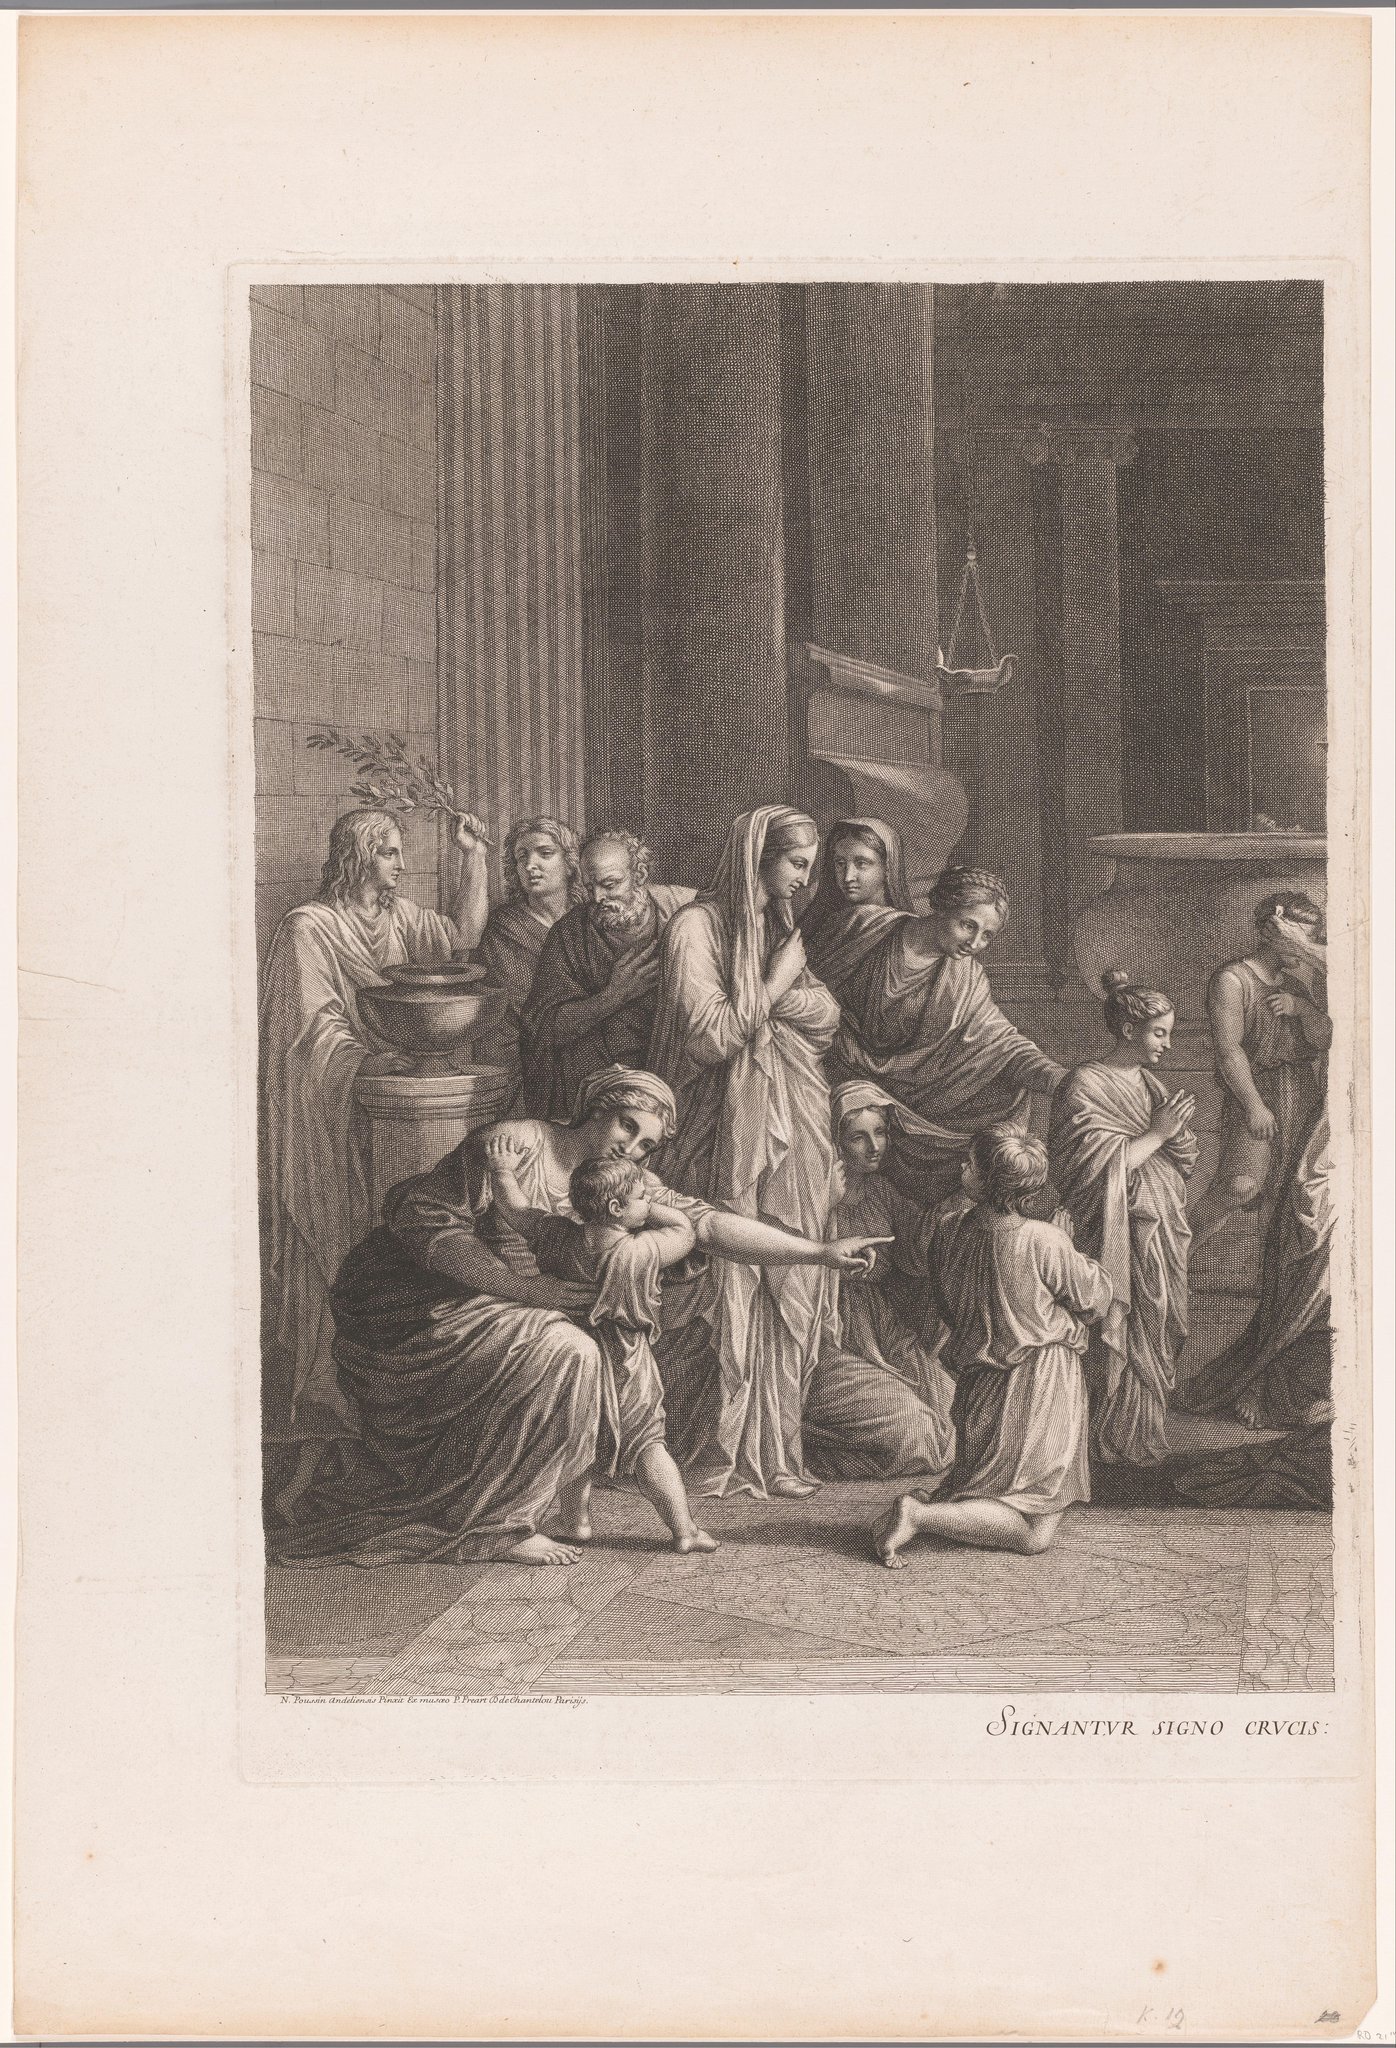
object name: print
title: Zeven sacramenten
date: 1680-1694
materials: paper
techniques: etching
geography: france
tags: confirmation ~ the second of the seven sacraments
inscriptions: collector's mark: Lugt 240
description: Prent maakt deel uit van een ongenummerde serie van zeven prenten.